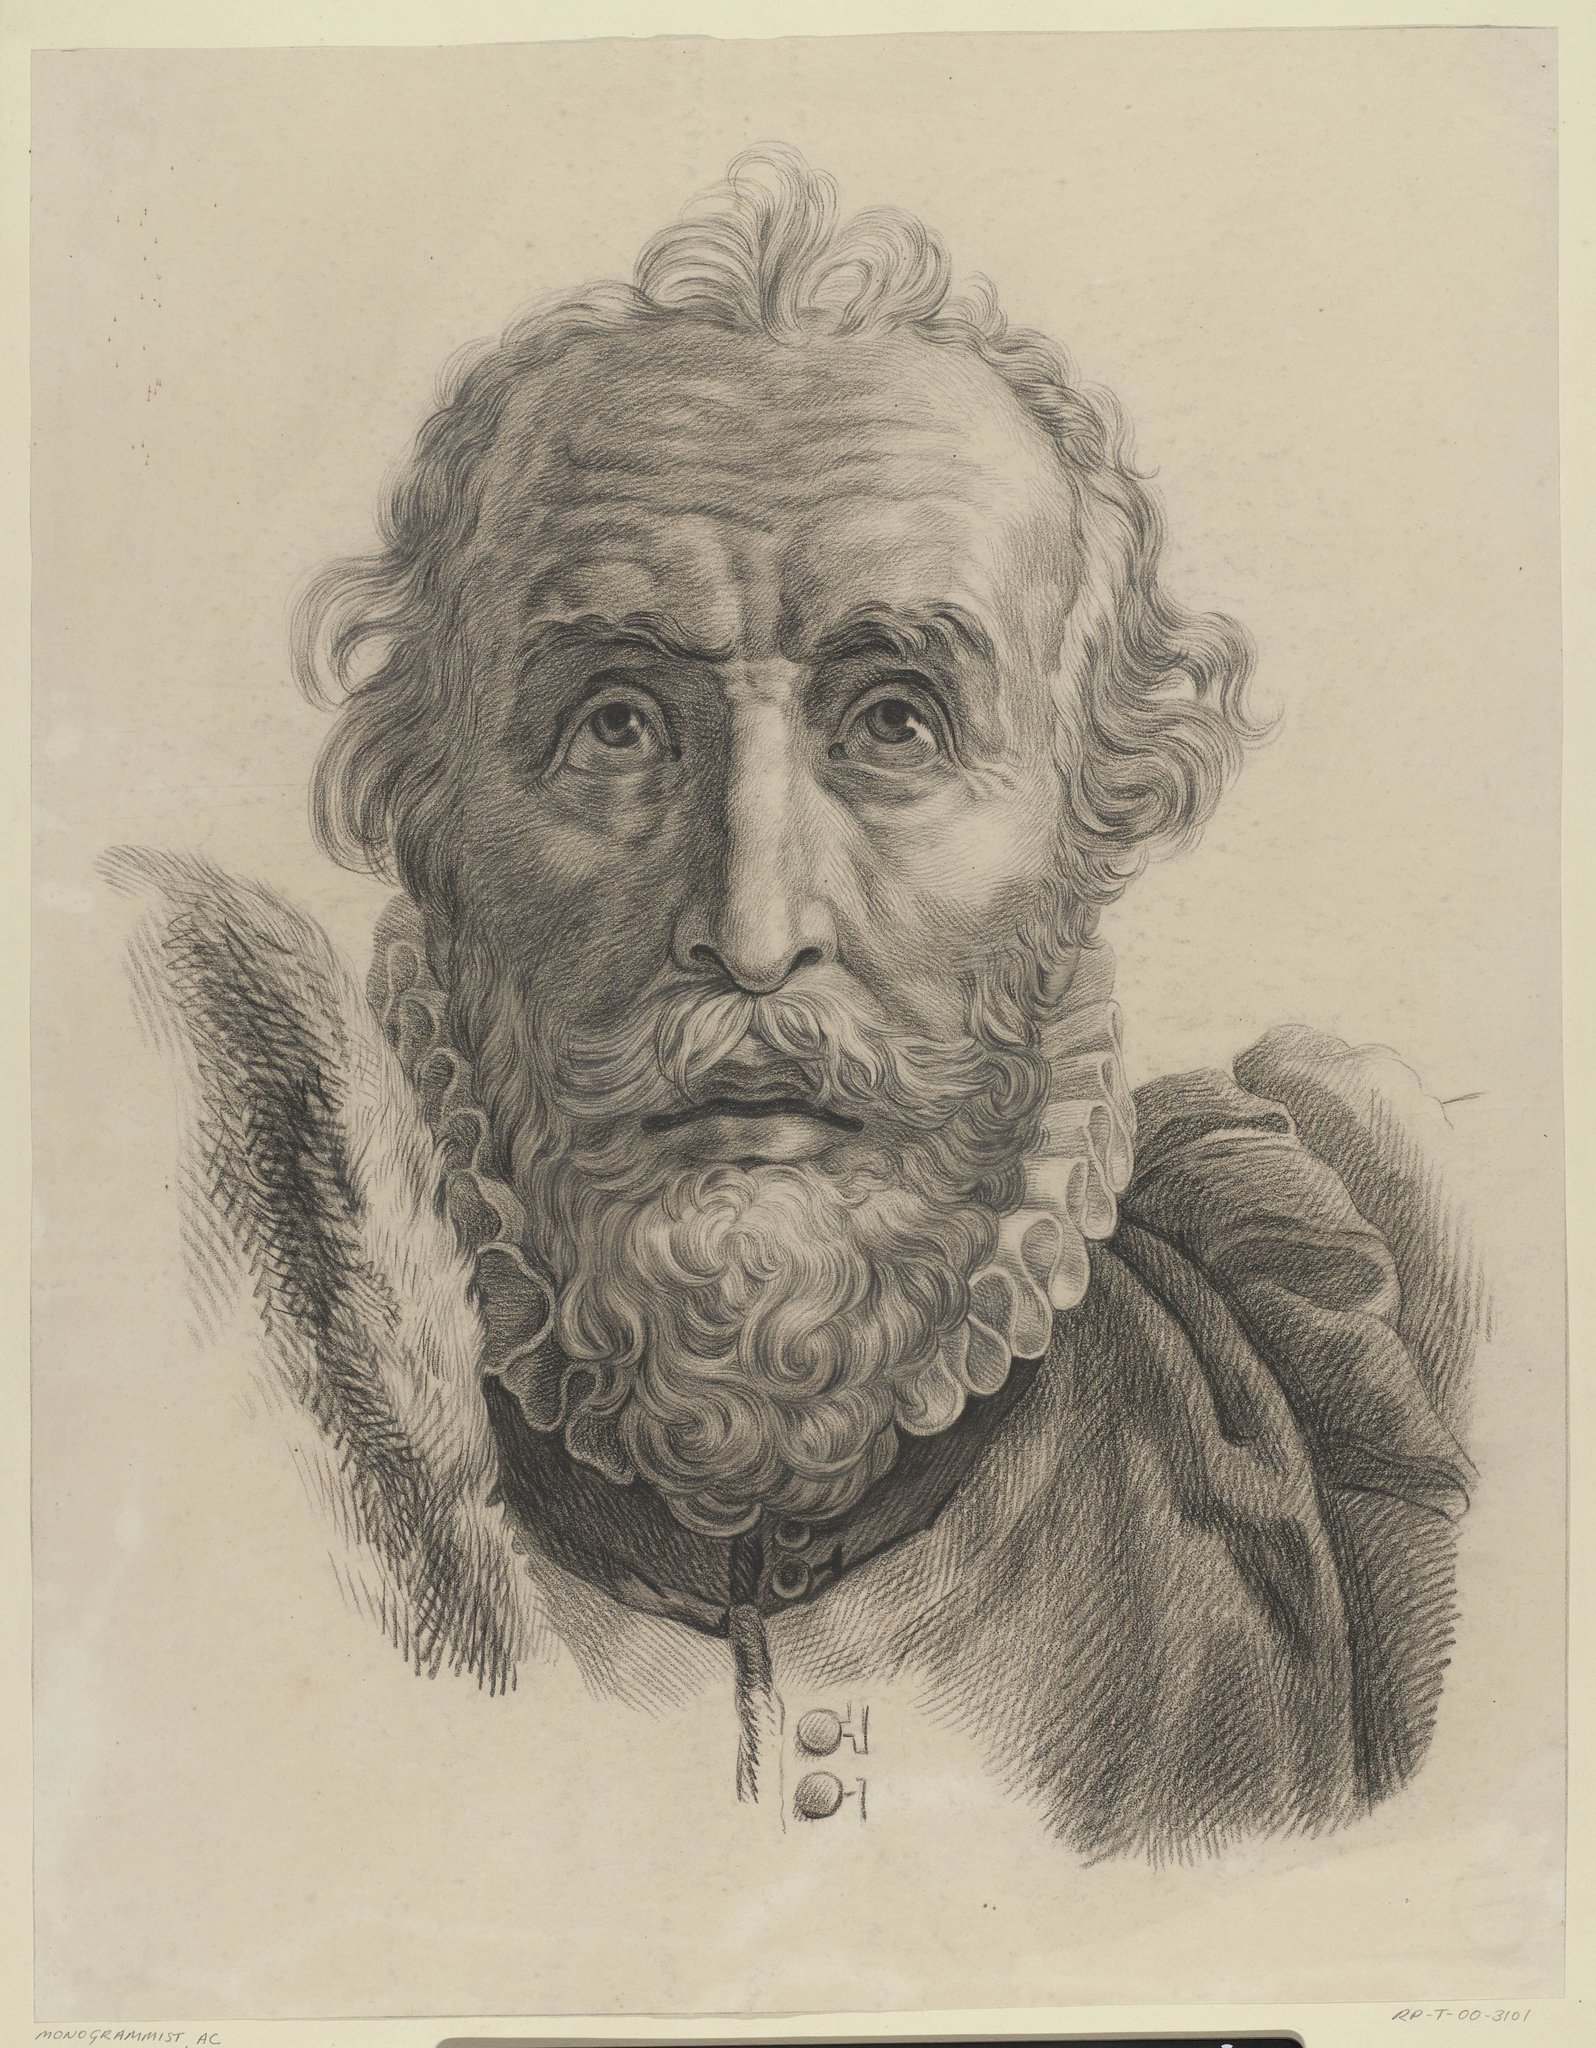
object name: drawing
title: Hoofd van een man met baard, van voren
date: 1830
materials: chalk, paper